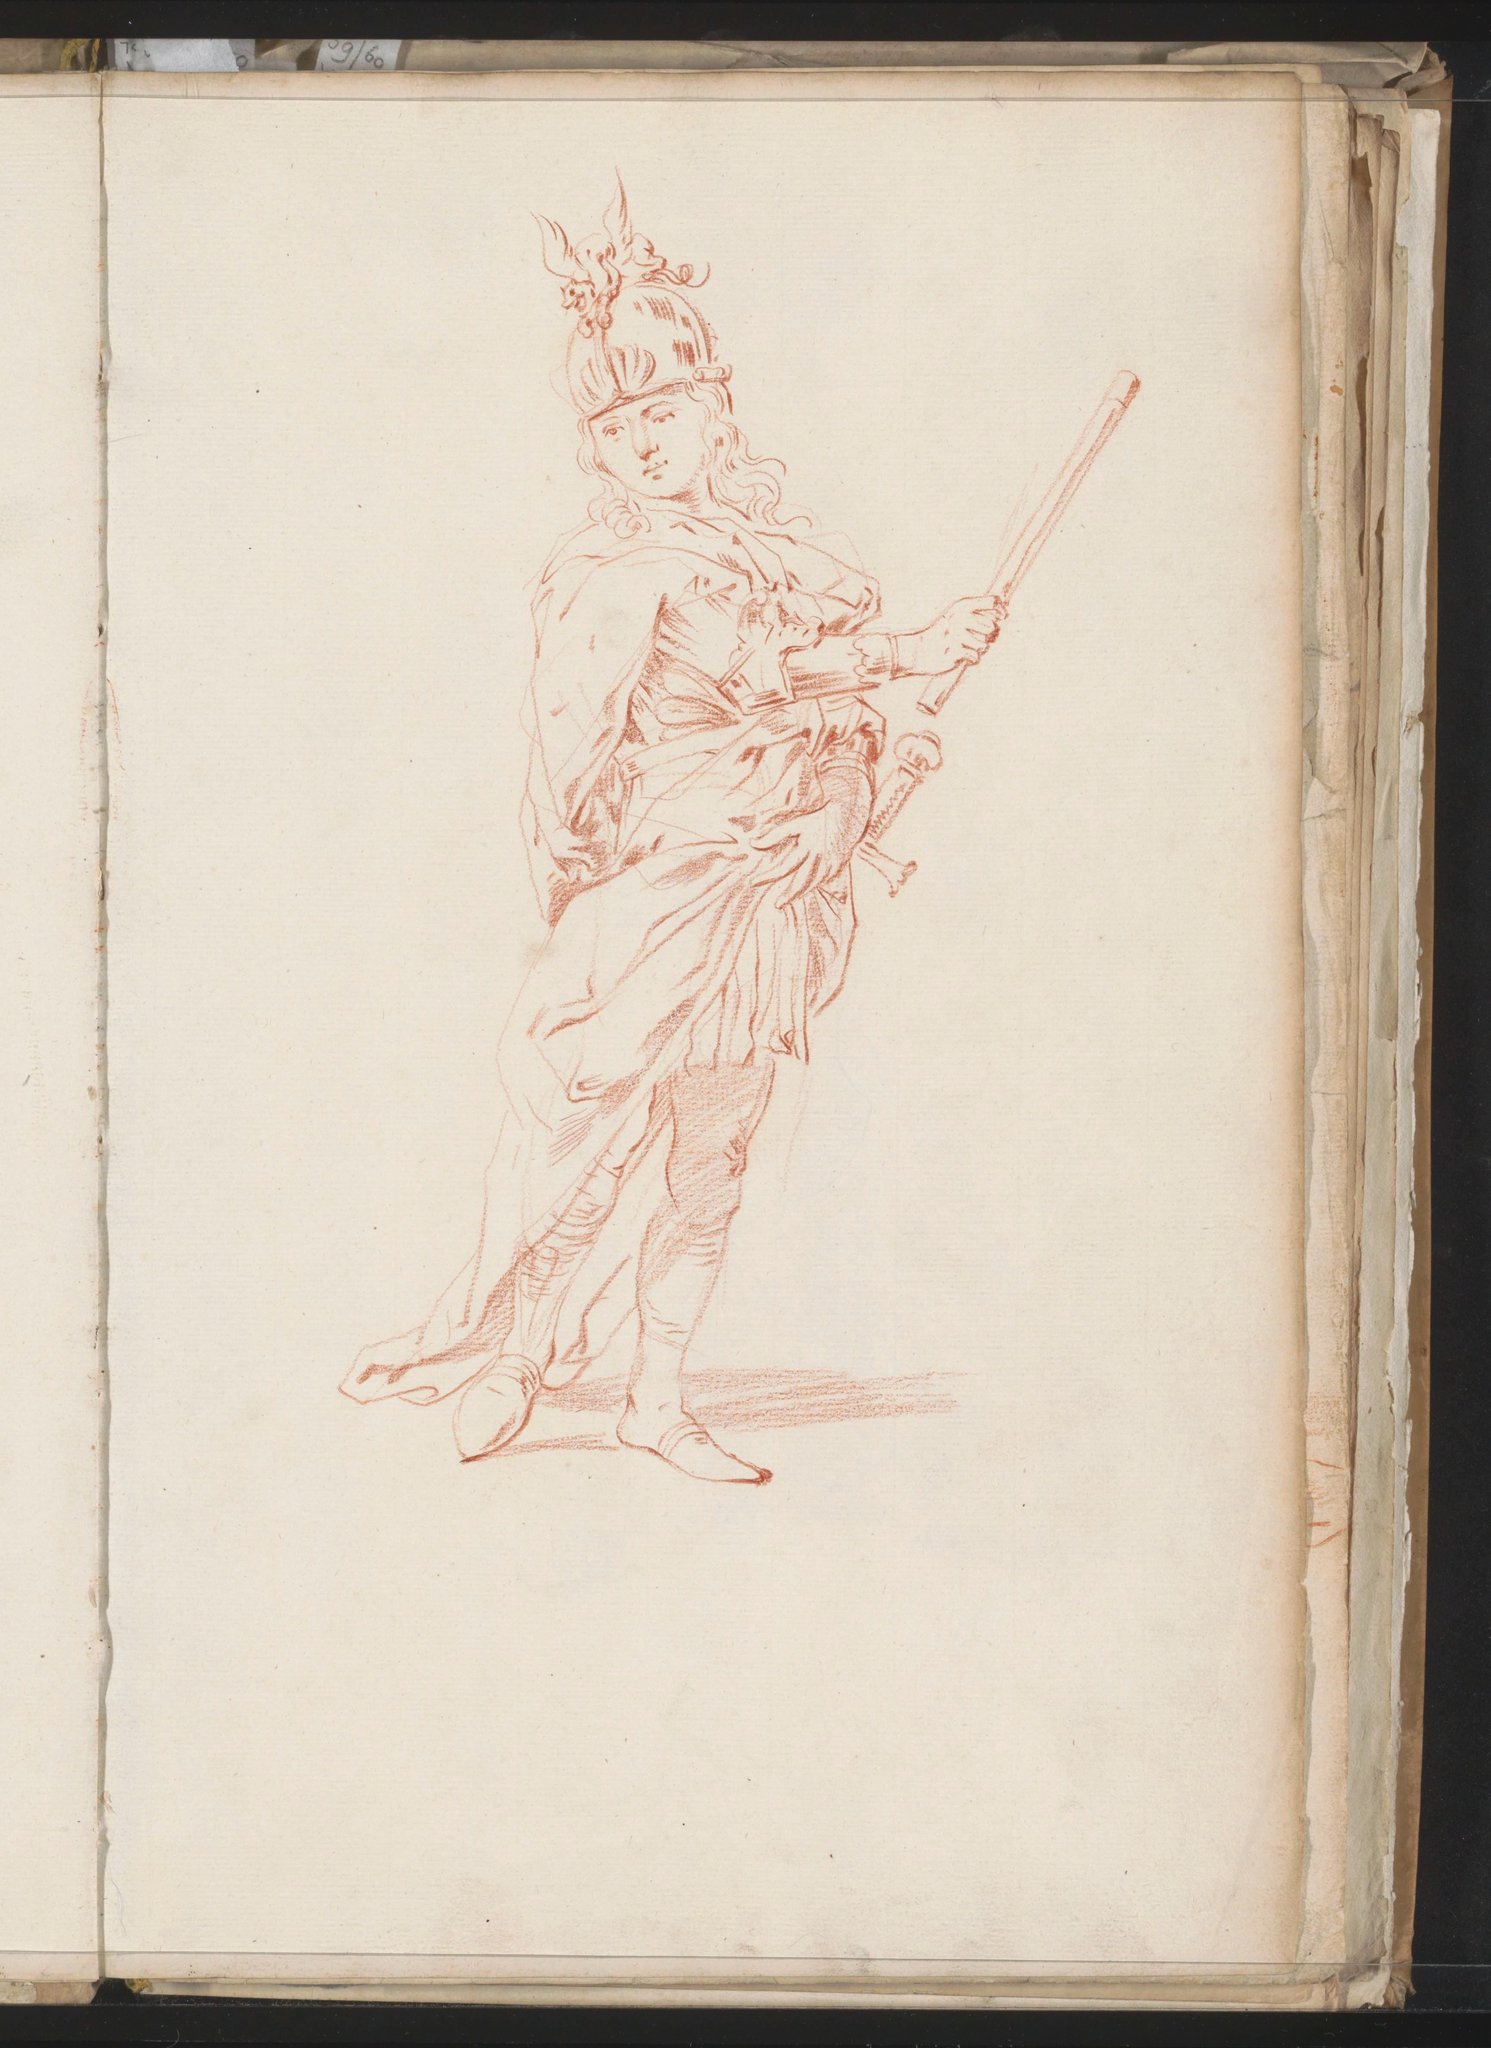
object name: sketchbook leaf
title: Perseus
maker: jacob toorenvliet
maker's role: draughtsman, painter, print maker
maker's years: 1640-1719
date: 1701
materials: chalk, paper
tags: (story of) perseus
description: Het heft van een zwaard steekt uit de plooien van het gewaad van Perseus. Met zijn rechterhand houdt hij een stok omhoog. Blad 4 recto uit een schetsboek met 63 bladen.